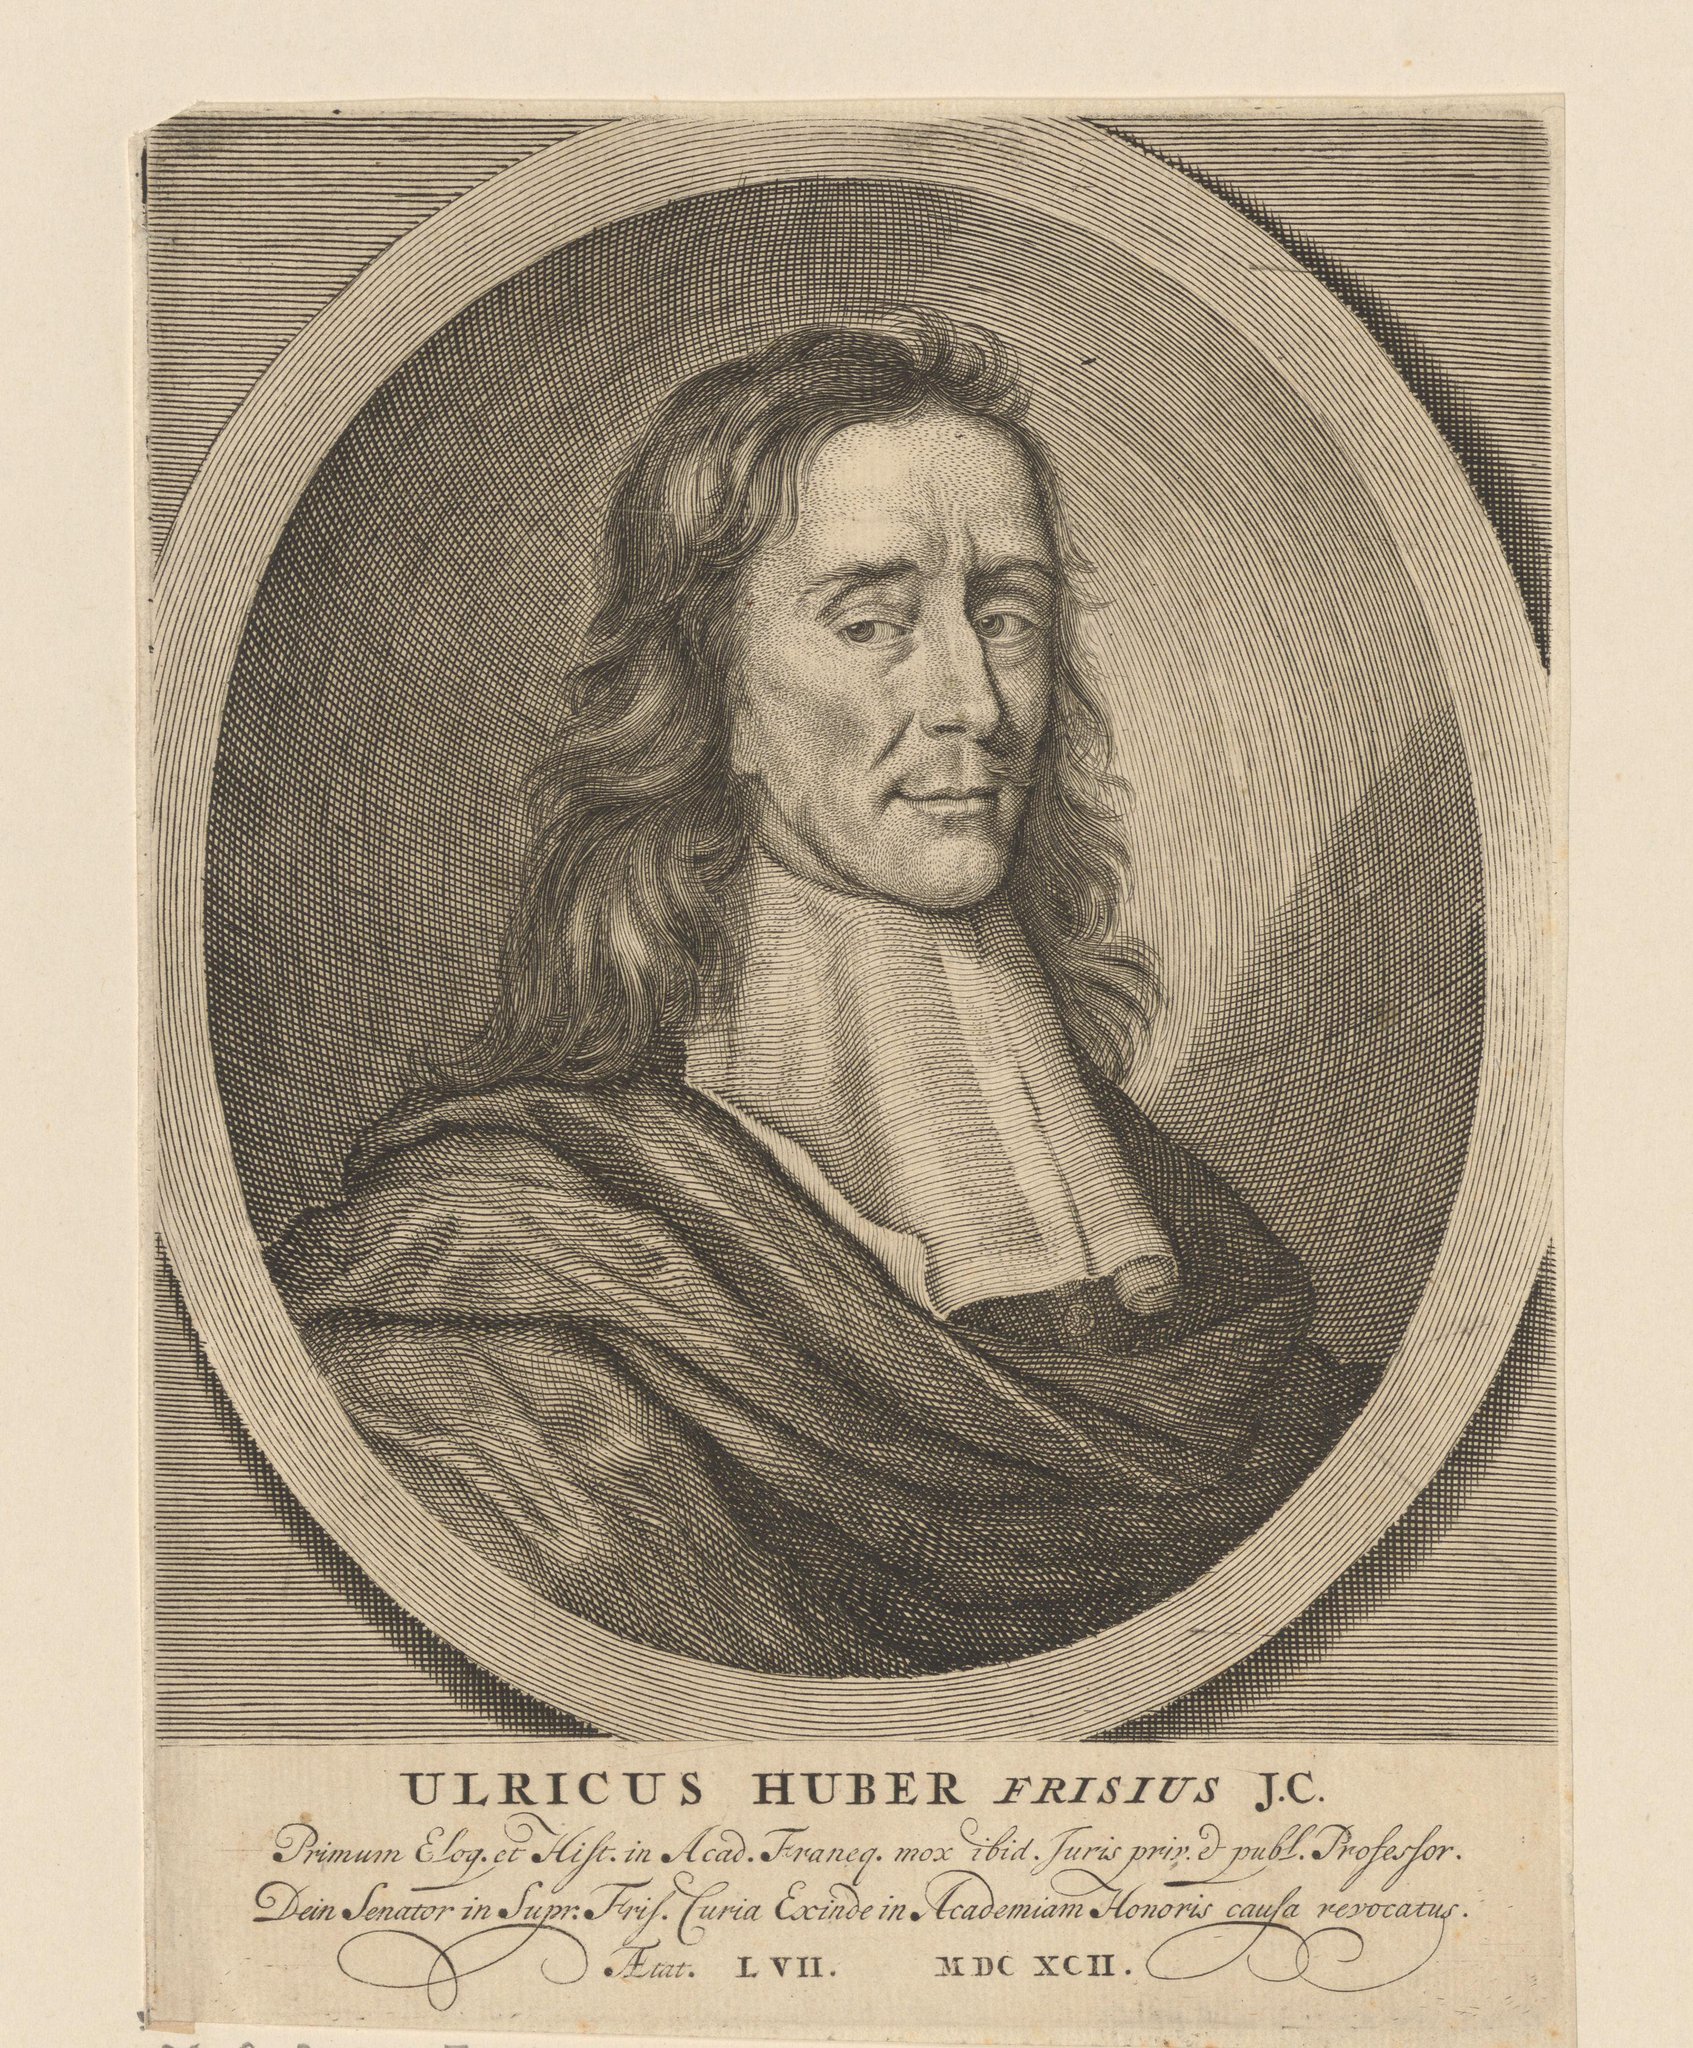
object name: print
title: Portret van Ulrik Huber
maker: Anonymous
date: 1692-1724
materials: paper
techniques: engraving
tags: historical persons, professor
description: Prent gebruikt in: Huber, Ulrik. Eunomia romana sive censura censurae juris justinianaei (...). Franeker: Leonardus Strick, 1700. Prent mogelijk ook gebruikt in andere publicaties.